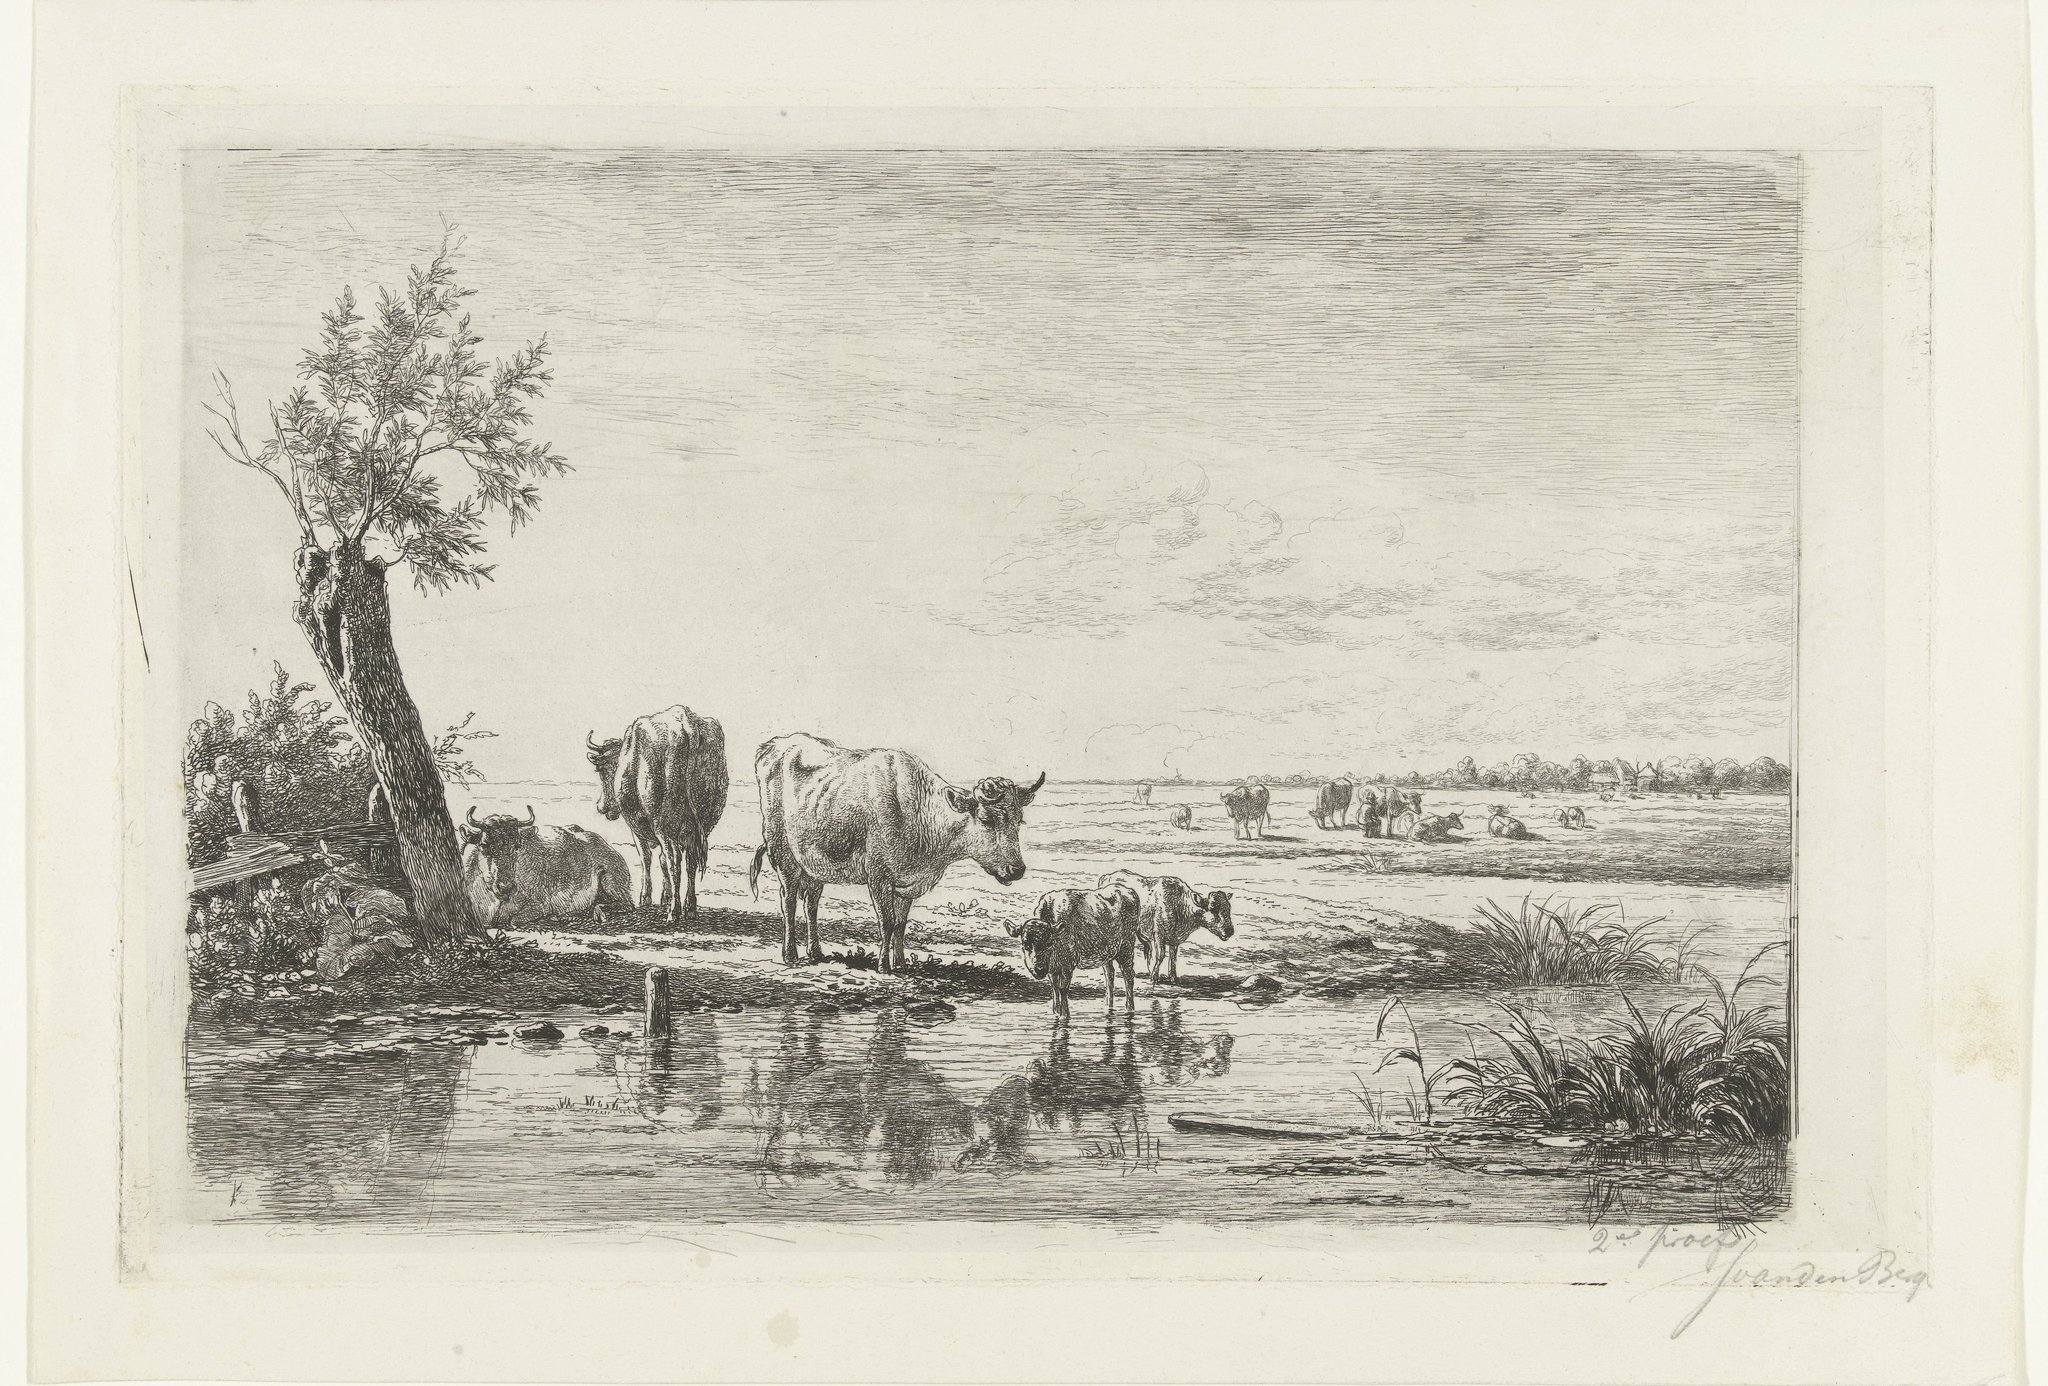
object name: print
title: Weidelandschap met koeien bij water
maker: simon van den berg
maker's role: draughtsman, print maker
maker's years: 1812-1891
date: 1822-1885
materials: paper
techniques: drypoint, etching, roulette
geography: netherlands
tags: cow, water meadows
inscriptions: collector's mark: Lugt 2228